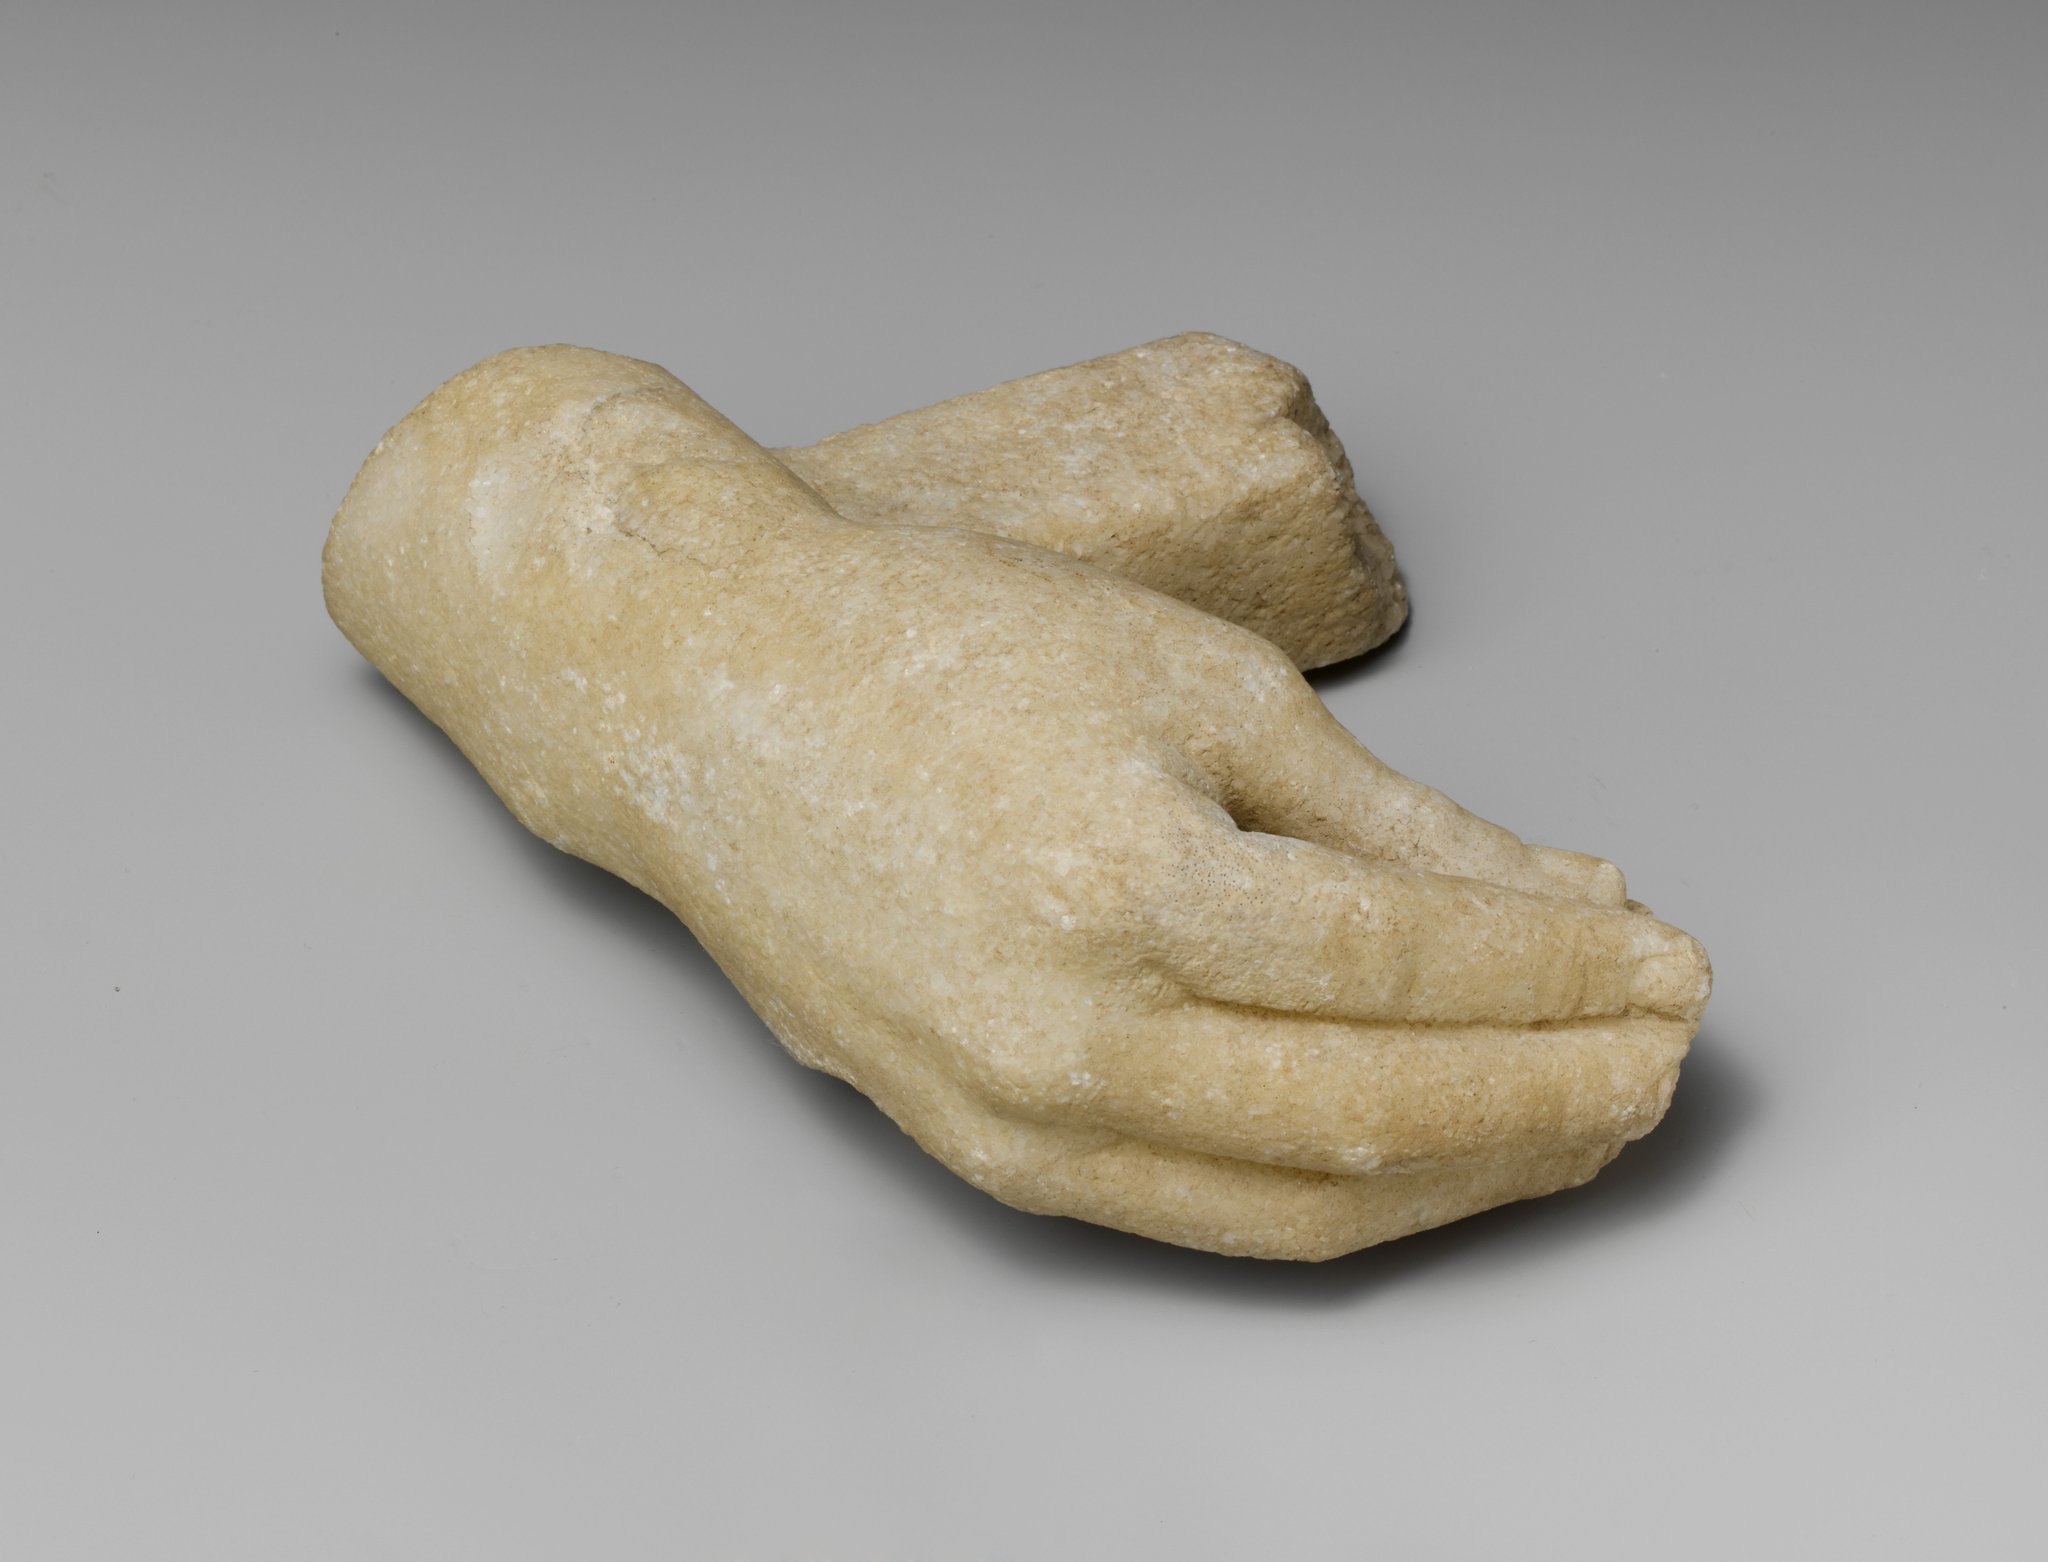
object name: hand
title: Marble right hand and wrist with a supporting strut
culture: roman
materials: marble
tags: hands